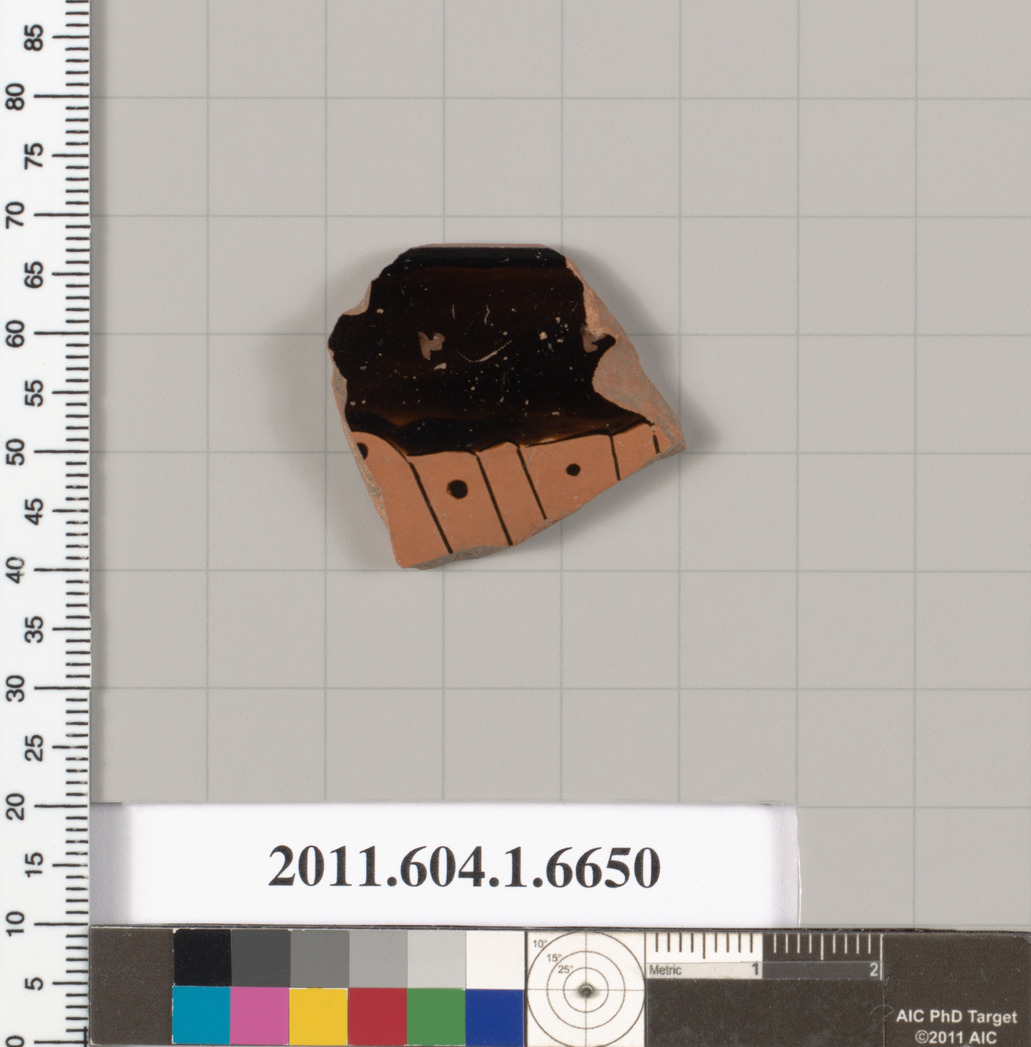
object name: kylix fragment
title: Terracotta rim fragment of a kylix (drinking cup)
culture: greek, attic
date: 490-470 BCE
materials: terracotta